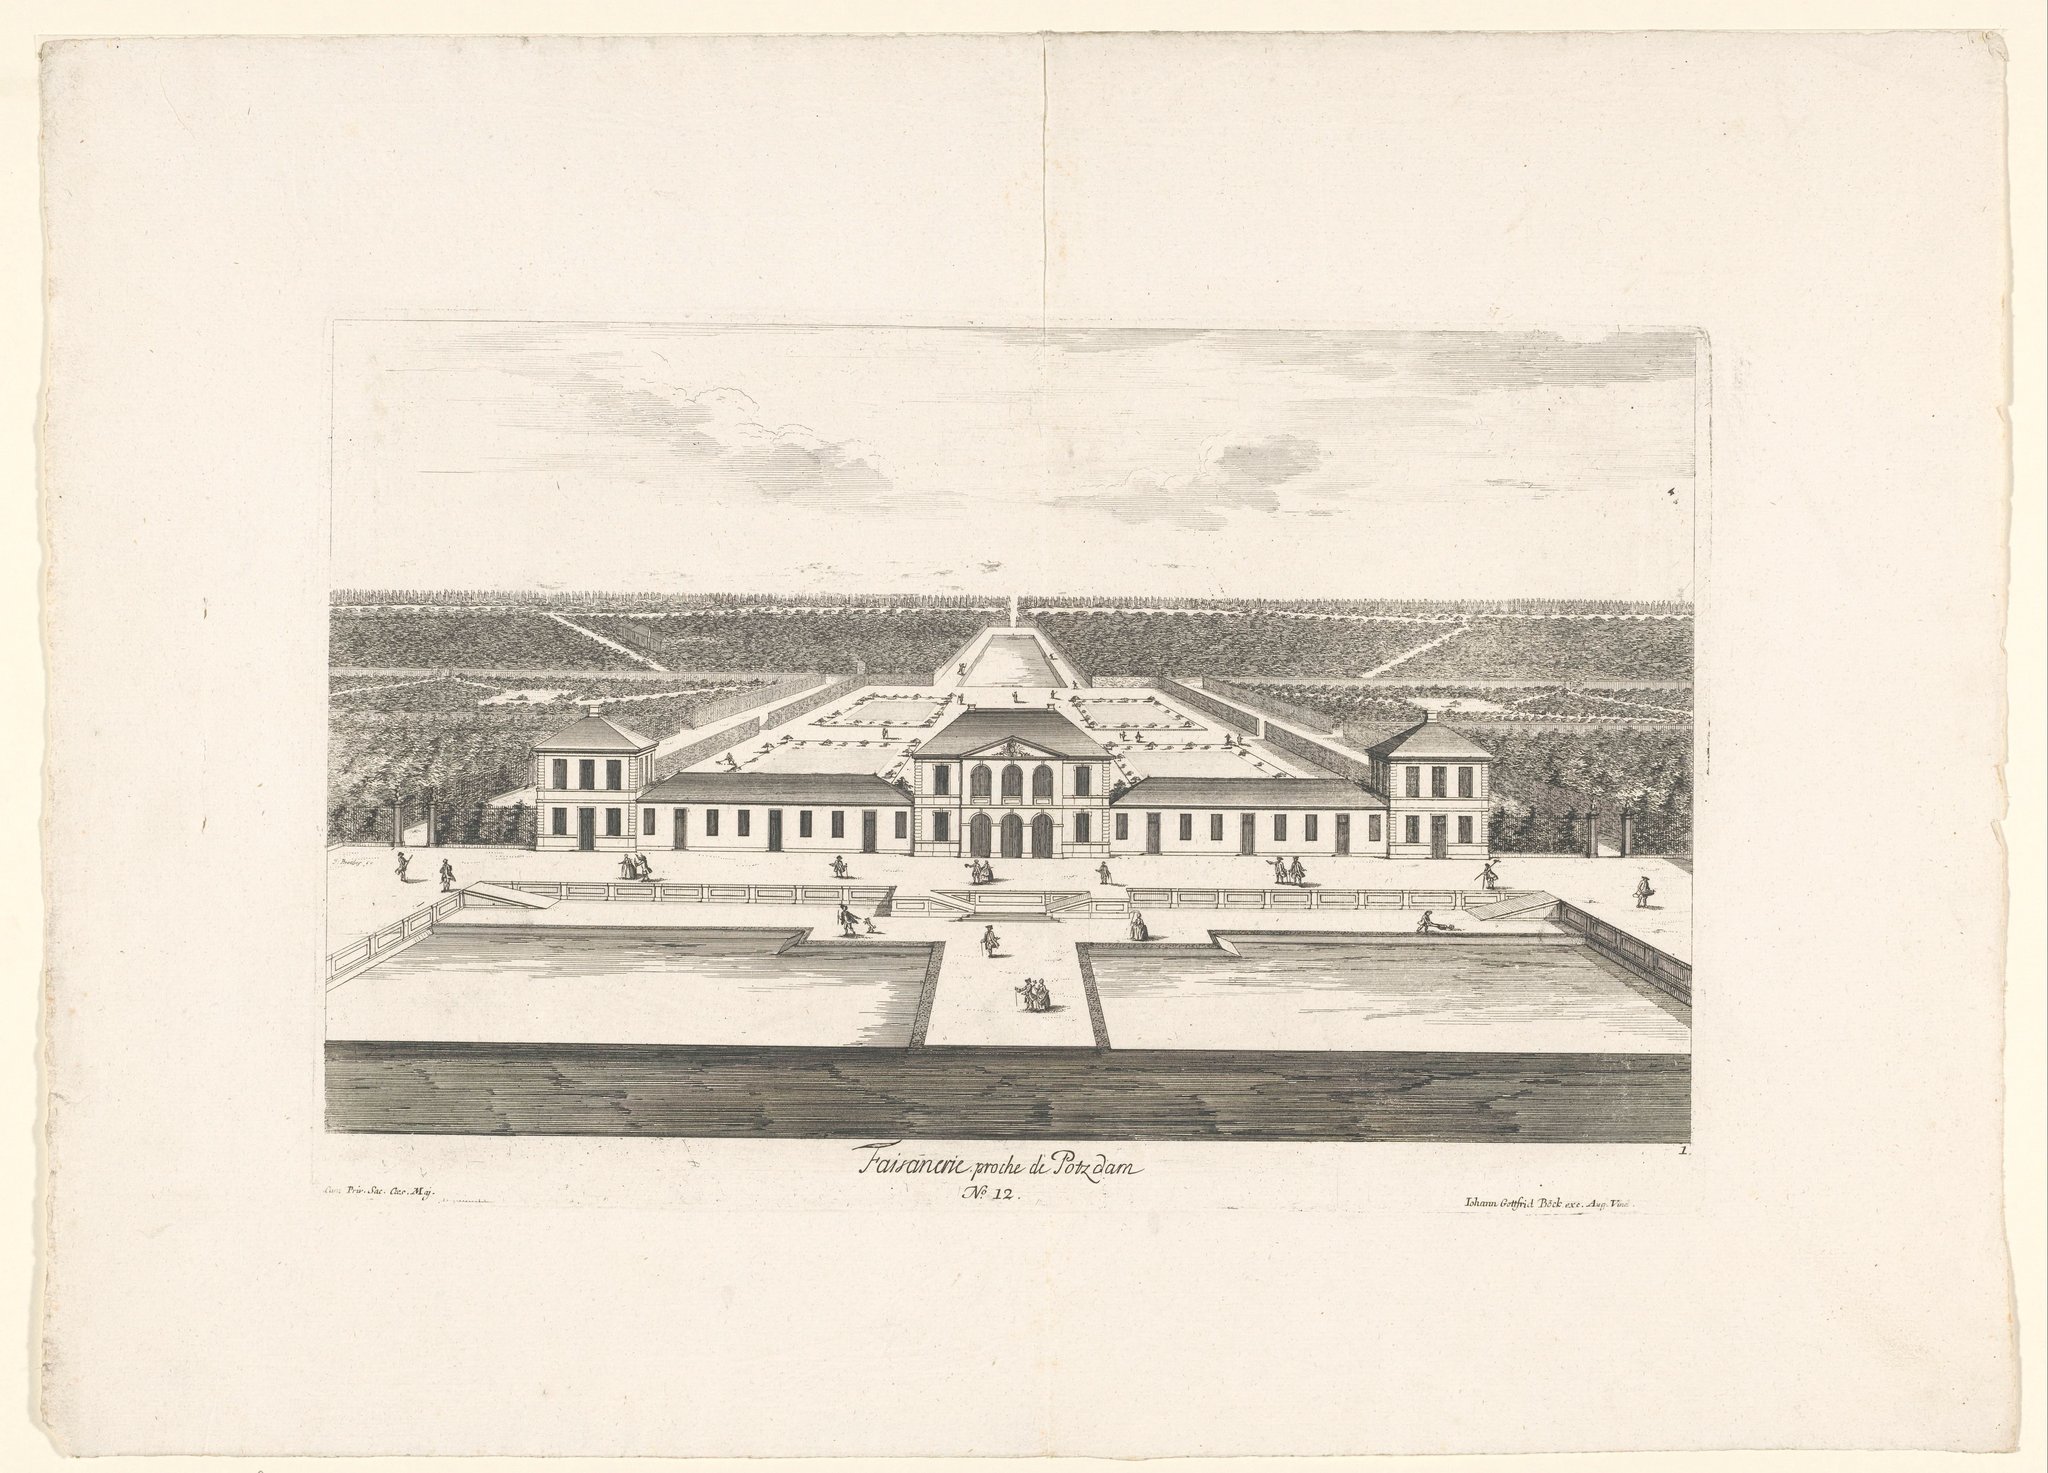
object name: book illustration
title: Faisanerie, proche de Potzdam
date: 1751-1808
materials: paper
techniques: etching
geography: augsburg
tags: palace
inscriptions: collector's mark: Lugt 2228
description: Gezicht op een Duits landhuis, in de buurt van Potsdam. Rechtsonder genummerd: 1.